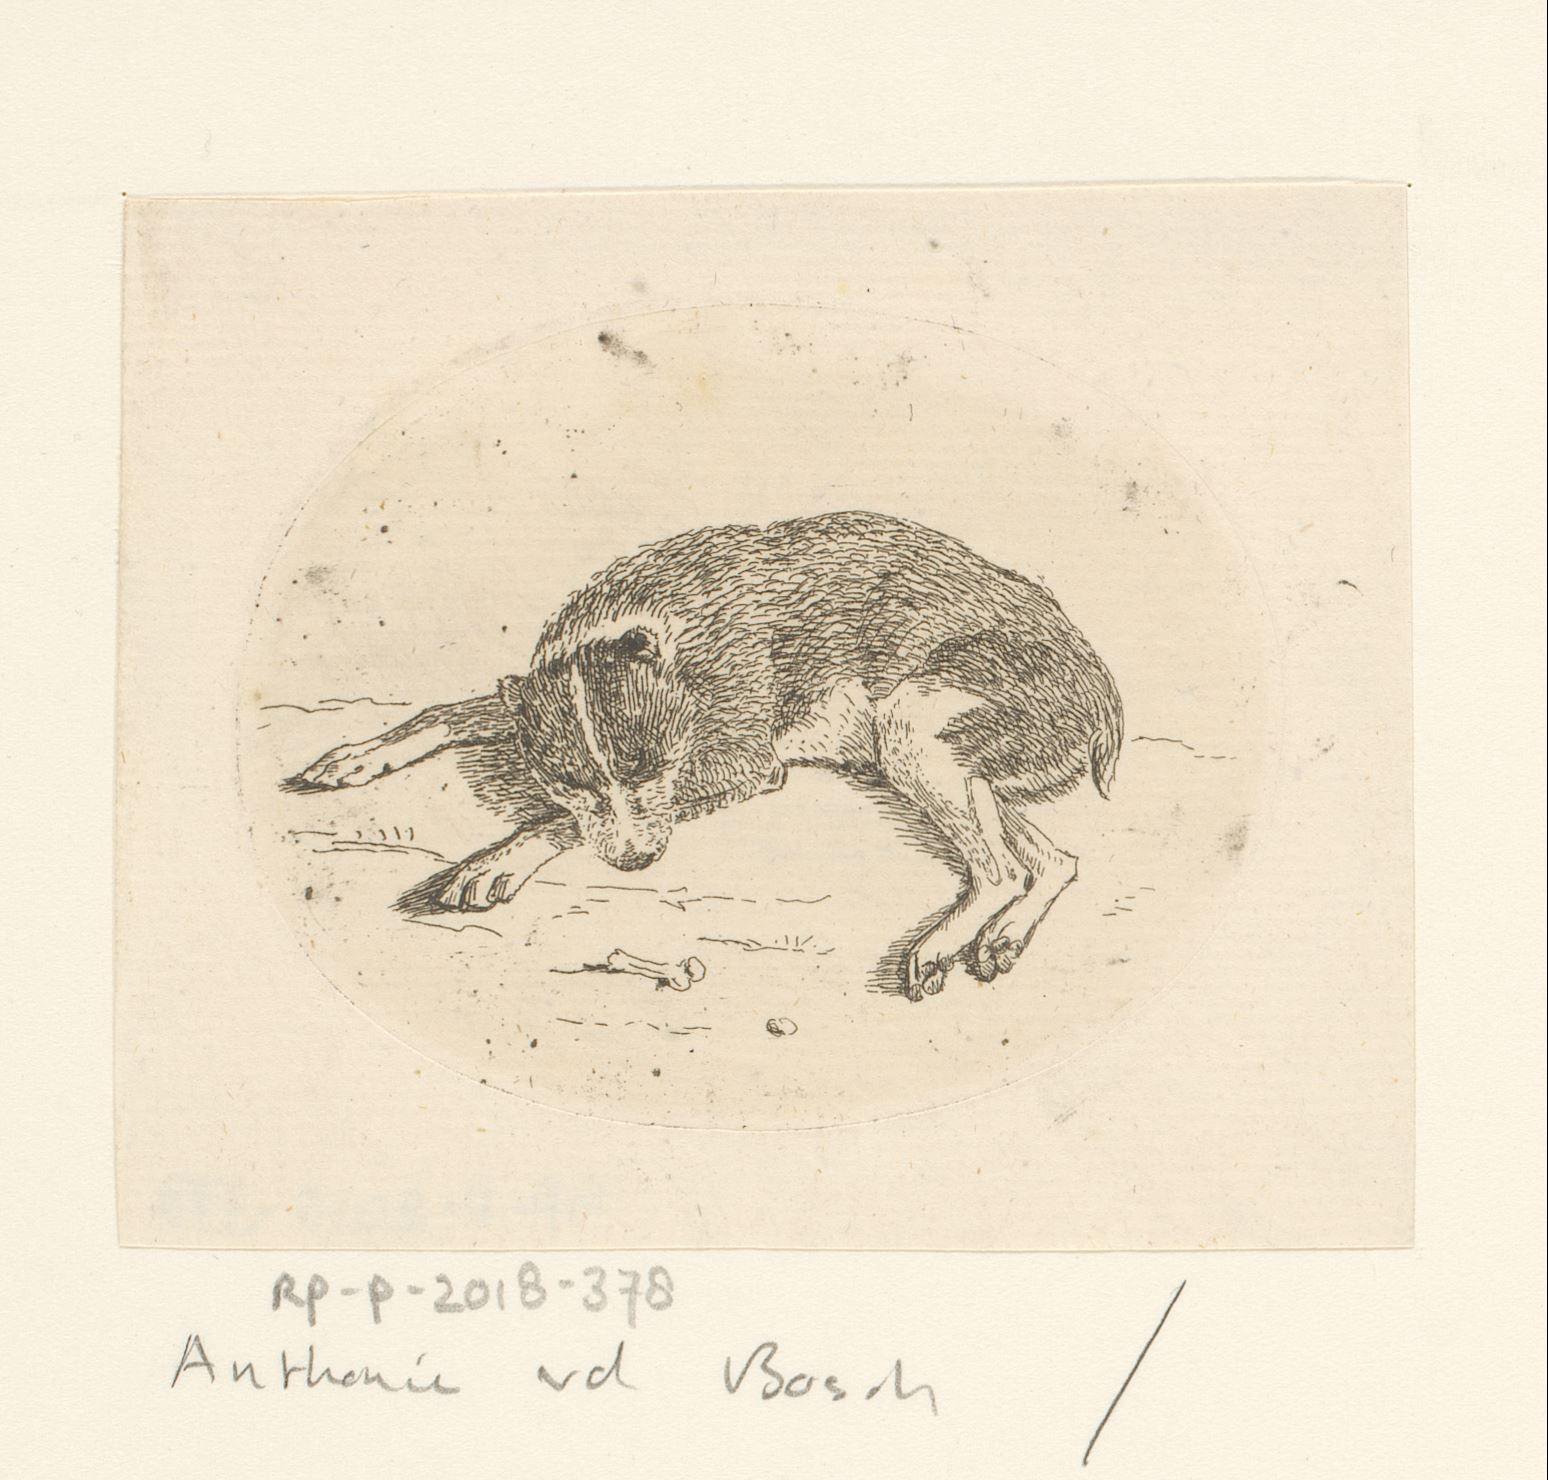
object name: print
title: Liggende hond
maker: anthonie van den bos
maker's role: draughtsman, print maker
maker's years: 1763-1838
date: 1778-1838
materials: paper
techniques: etching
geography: netherlands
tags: dog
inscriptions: collector's mark: Lugt 2228, collector's mark: Lugt 698